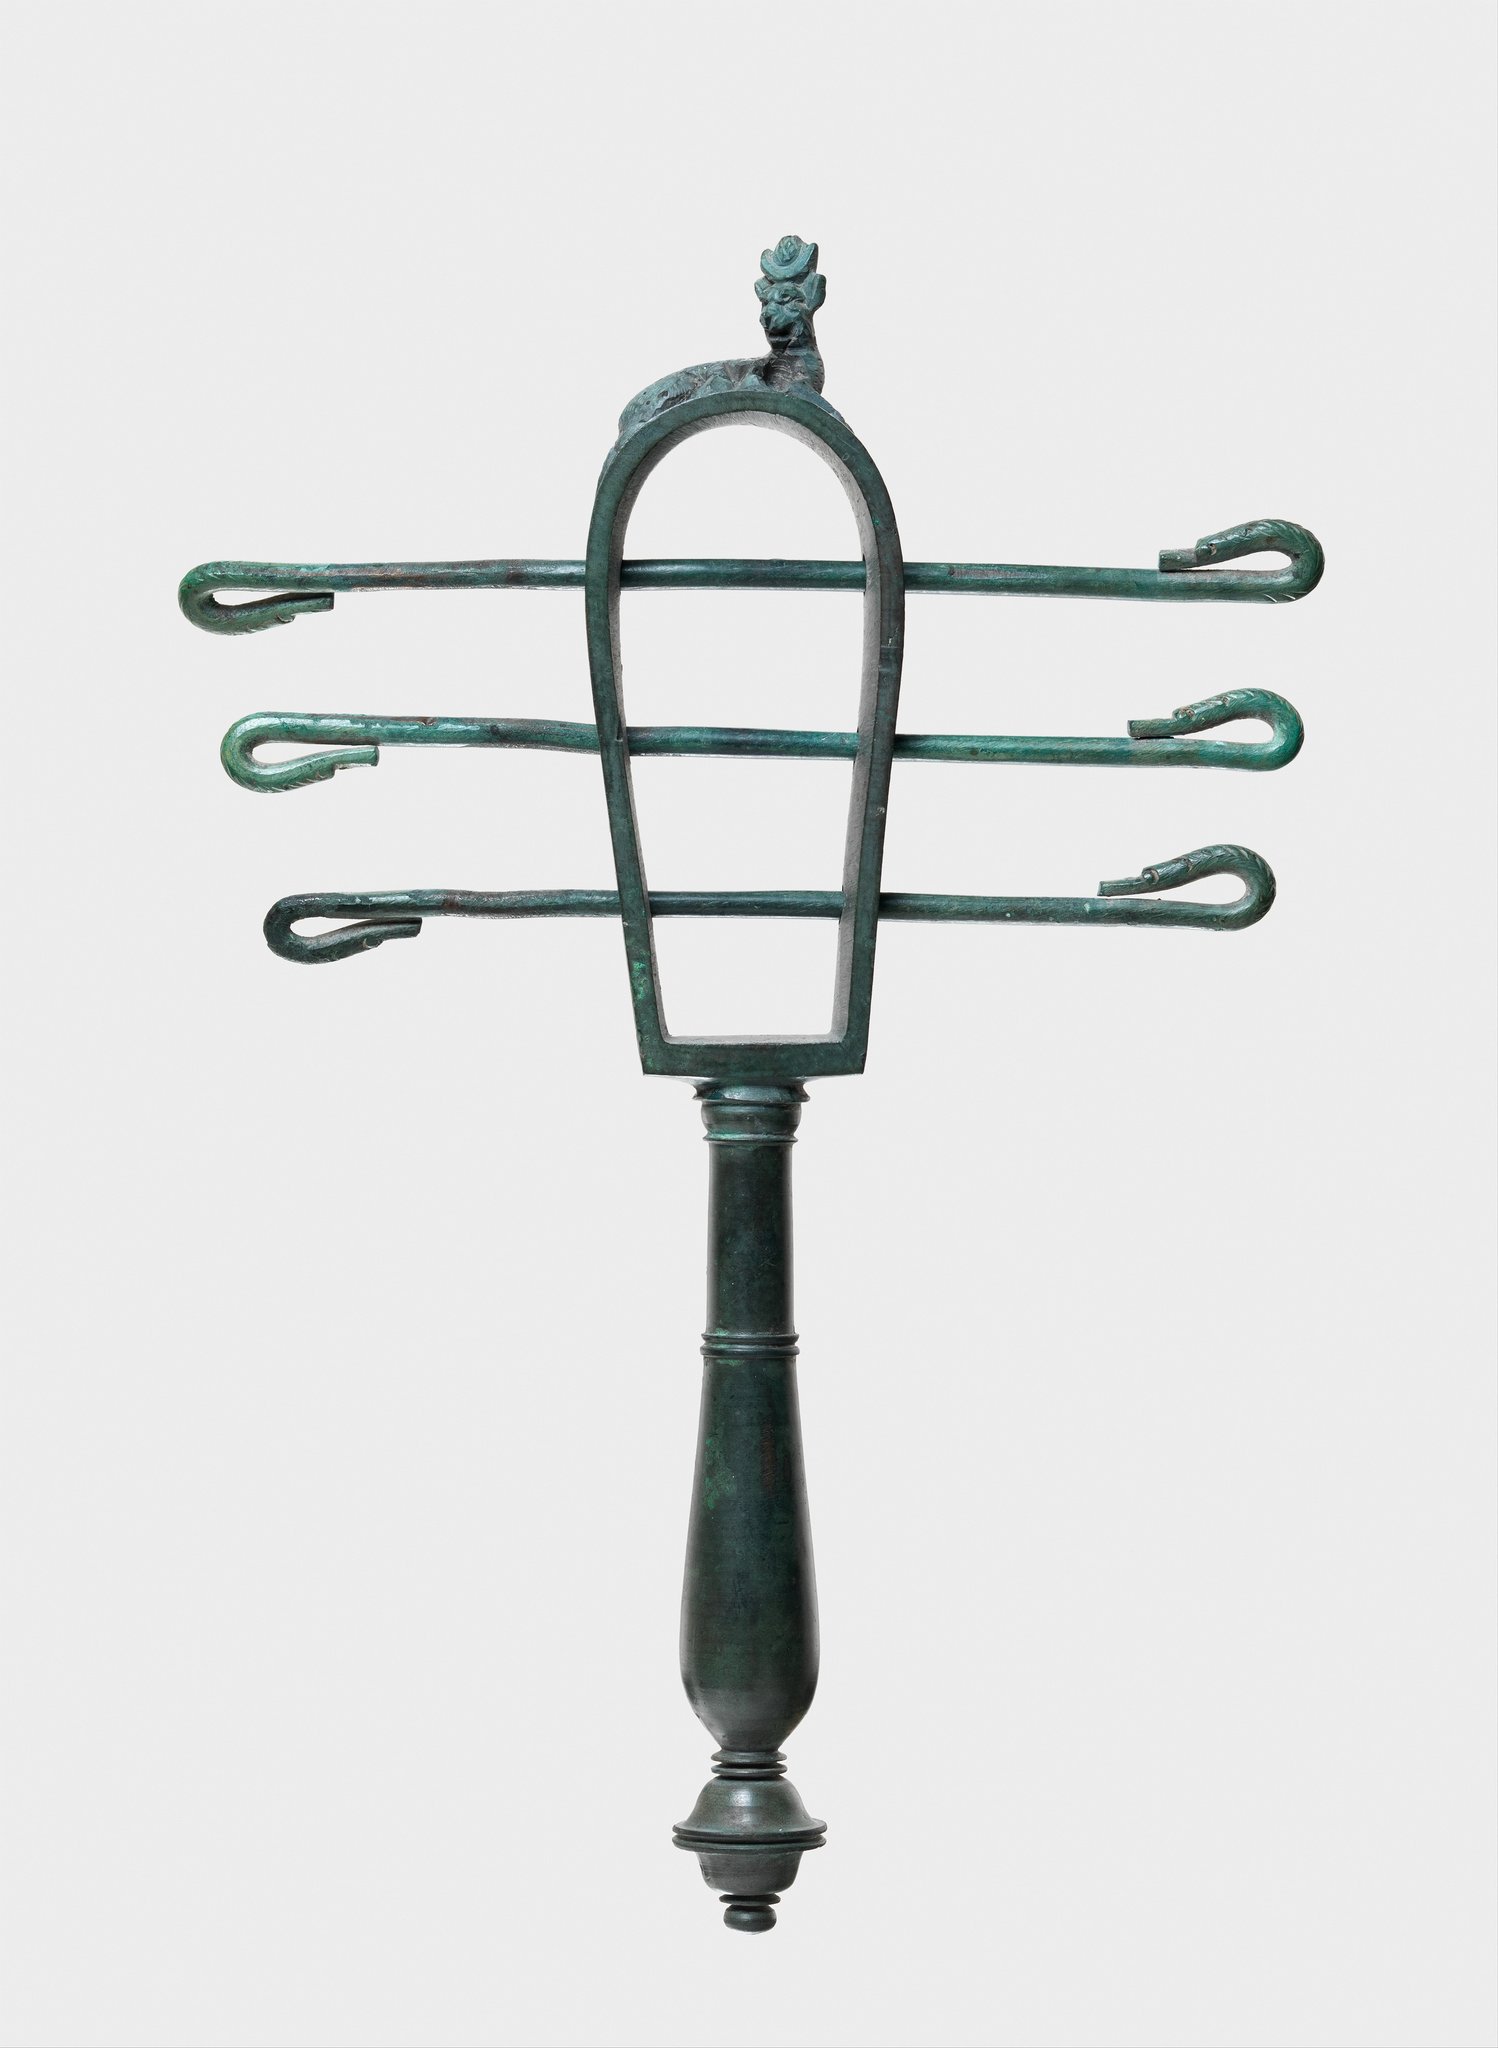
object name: music, sistrum, mother cat, duck's head terminal, arc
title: Sistrum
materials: bronze, copper alloy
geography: egypt or italy